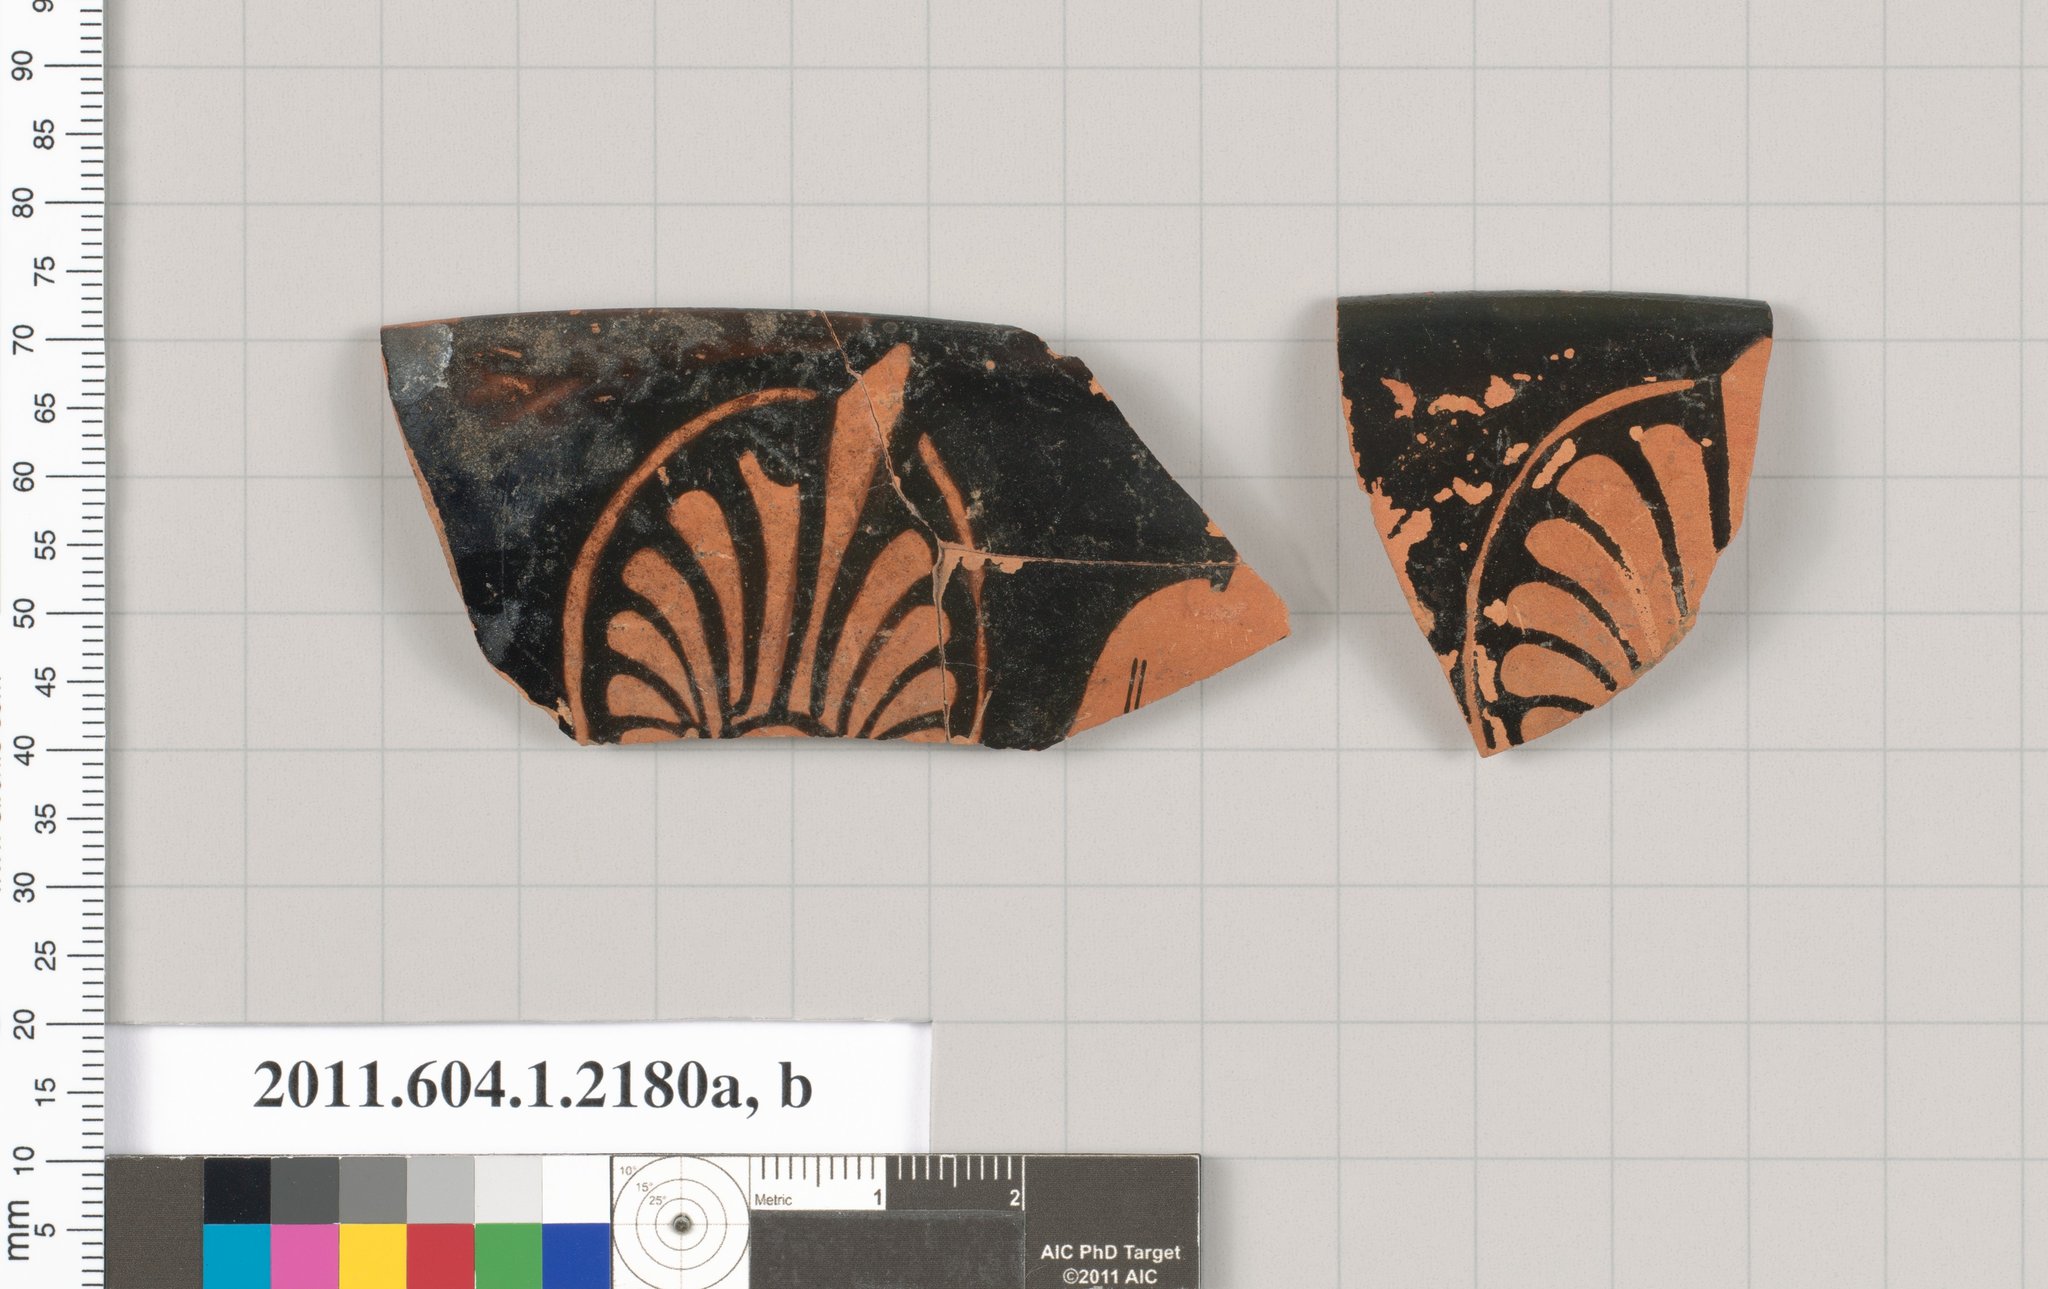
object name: kylix fragment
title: Terracotta rim fragments of a kylix (drinking cup)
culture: greek, attic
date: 467-435 BCE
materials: terracotta